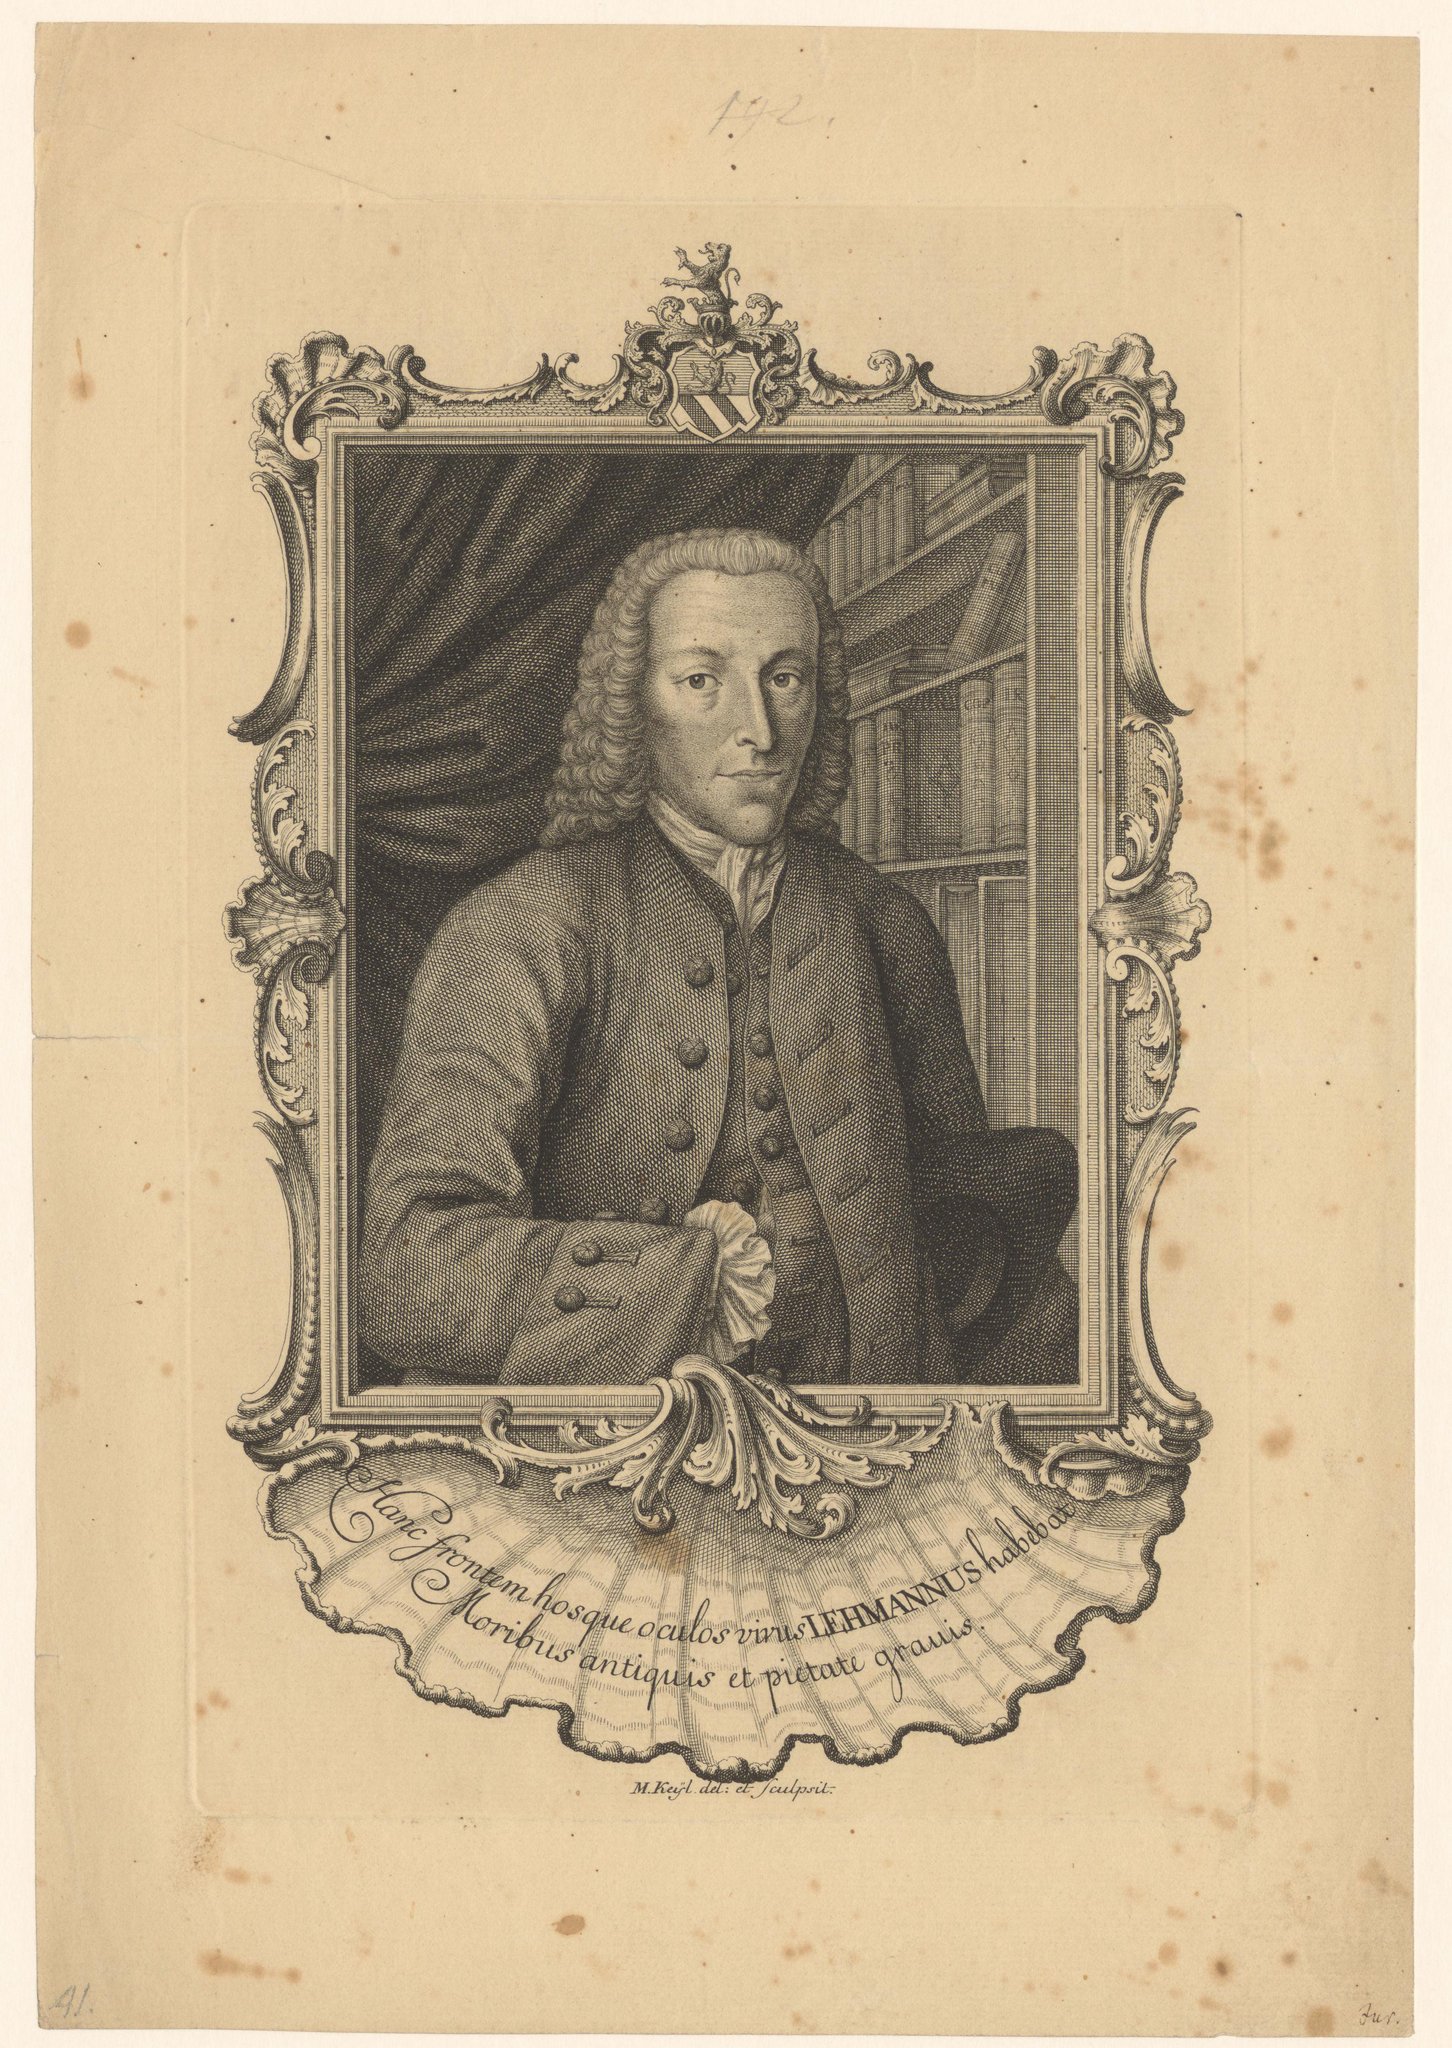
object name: print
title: Portret van de heer Lehmann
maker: michael keyl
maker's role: draughtsman, print maker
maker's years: 1722-1798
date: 1732-1798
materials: paper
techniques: engraving, etching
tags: historical persons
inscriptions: collector's mark: Lugt 2228